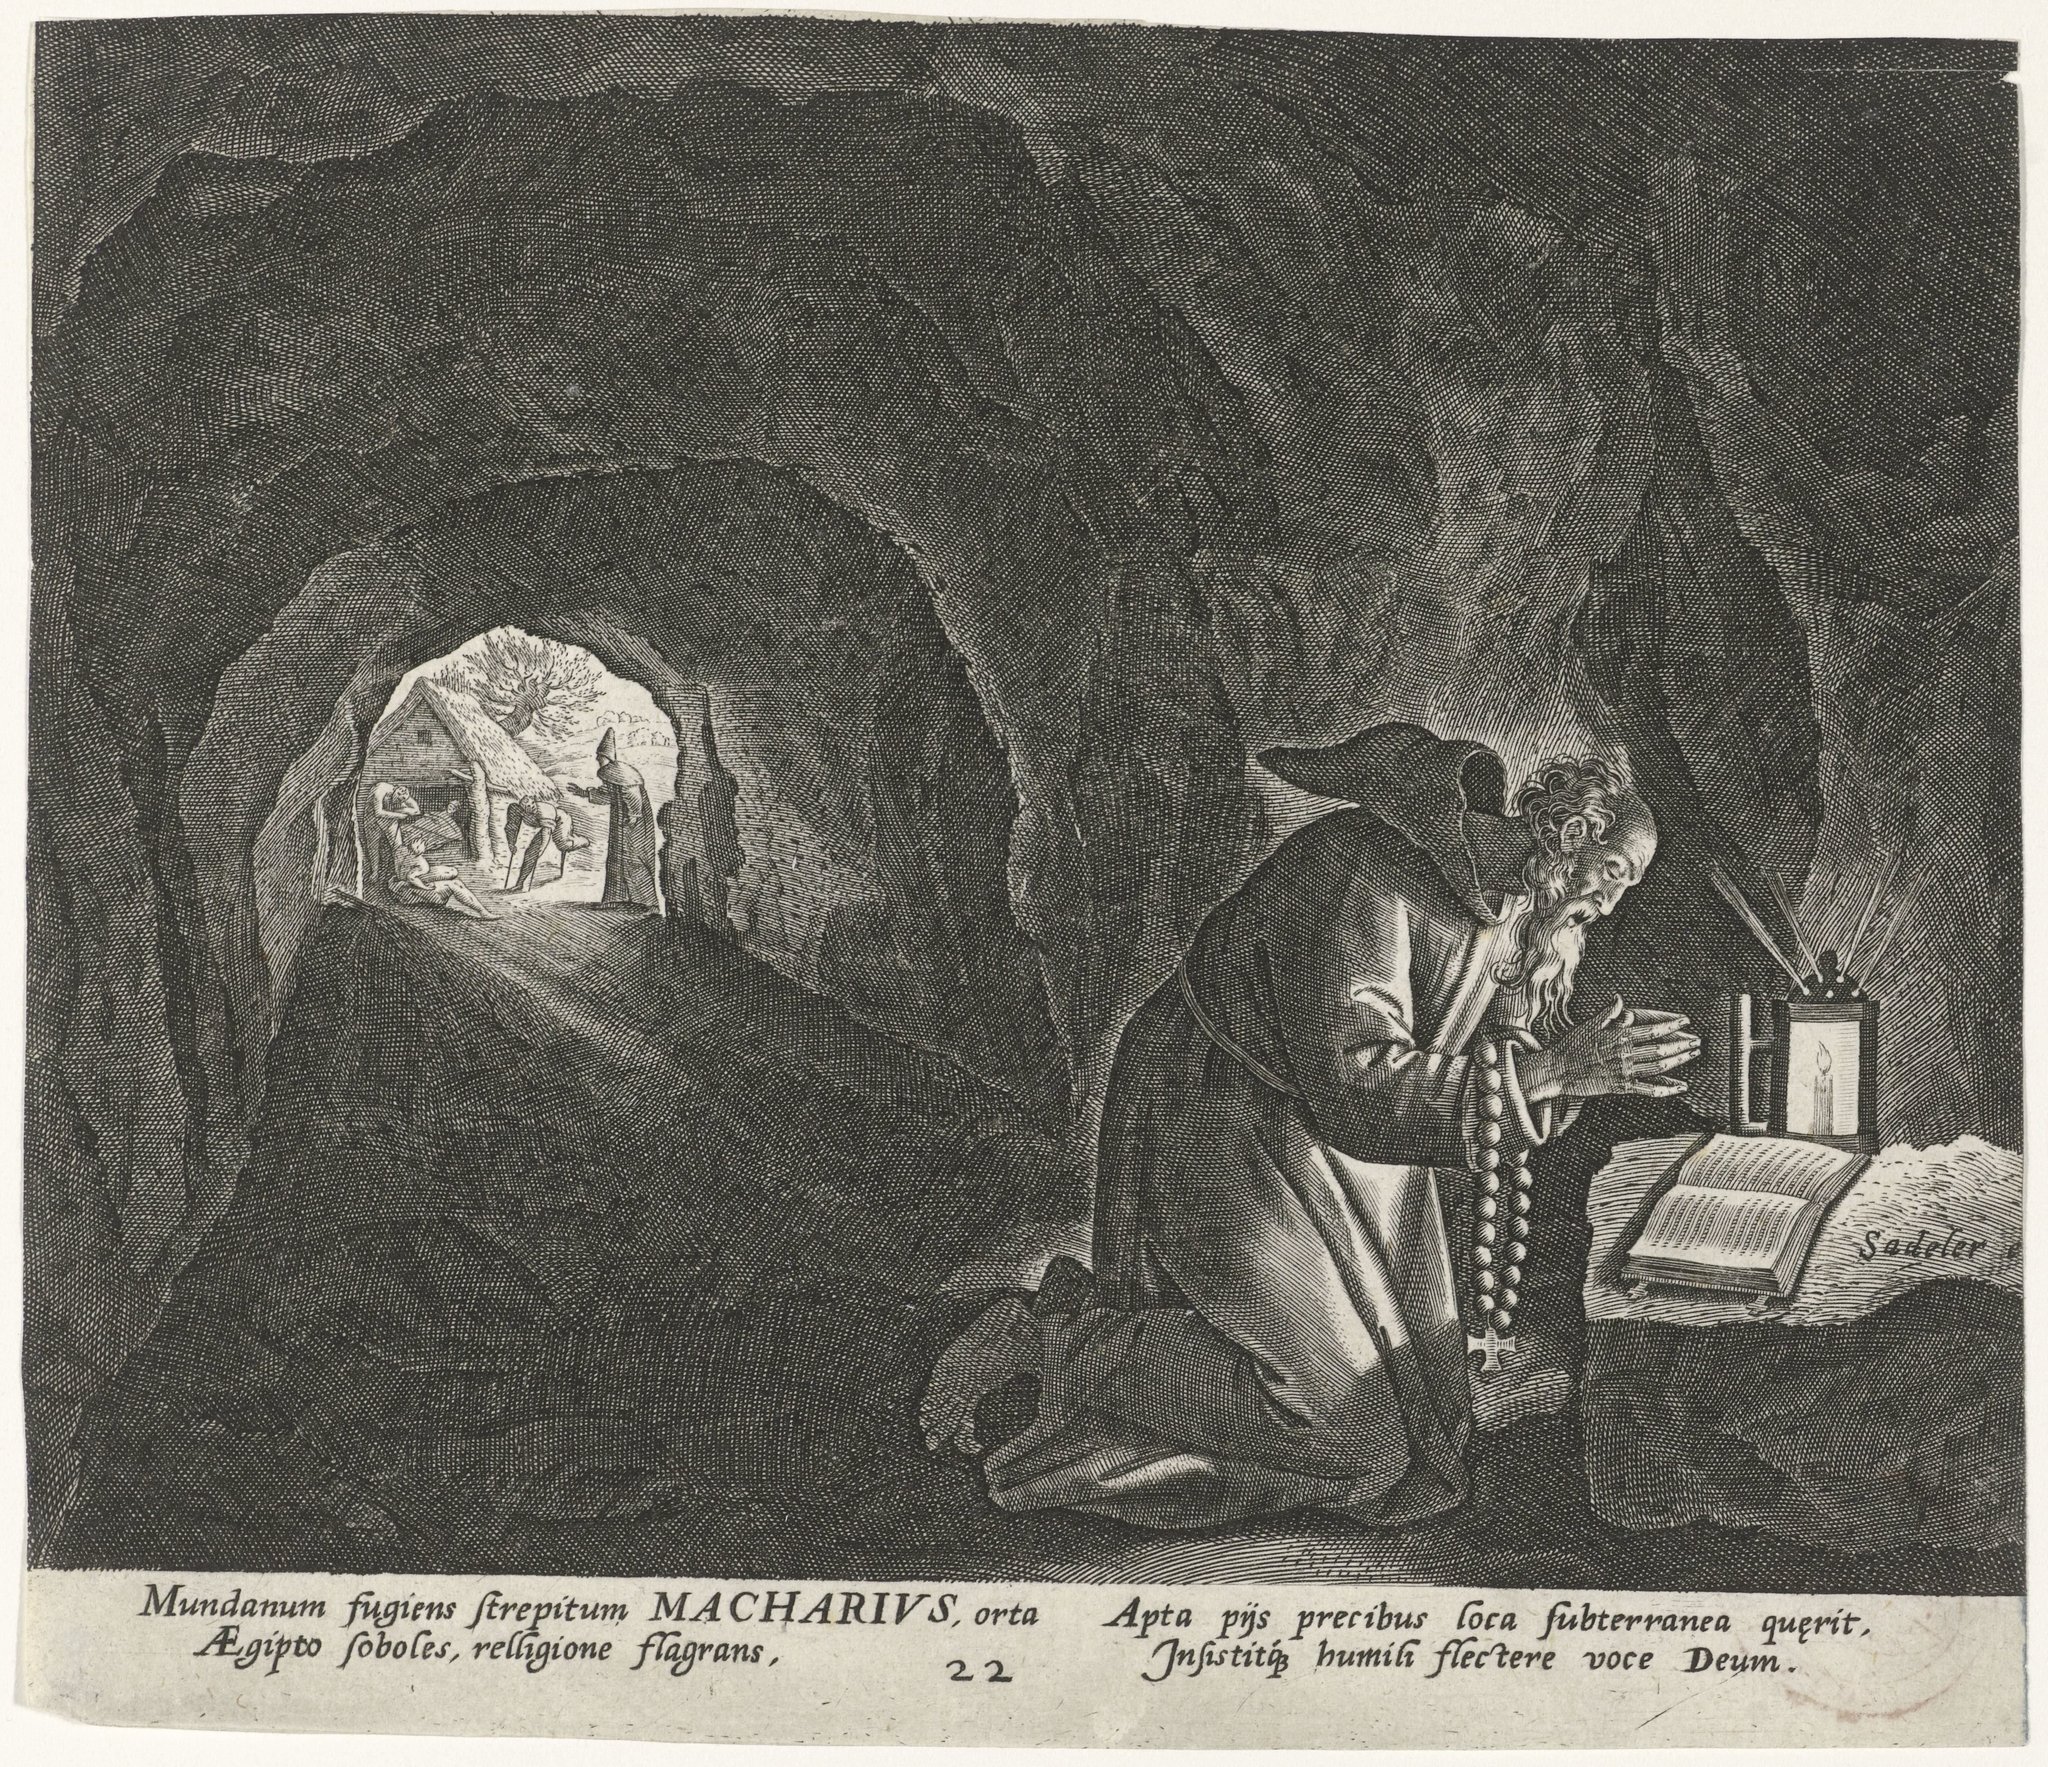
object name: print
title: Solitudo Sive Vitae Patrum Eremicolarum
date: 1583-1588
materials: paper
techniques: engraving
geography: antwerp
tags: male saints (with name), anchorite, hermit, cave, grotto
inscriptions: collector's mark: Lugt 240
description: De H. Macarius van Egypte als kluizenaar in een grot. Hij zit geknield te bidden voor een bijbel. Op de achtergrond andere kluizenaars met bedelaars.